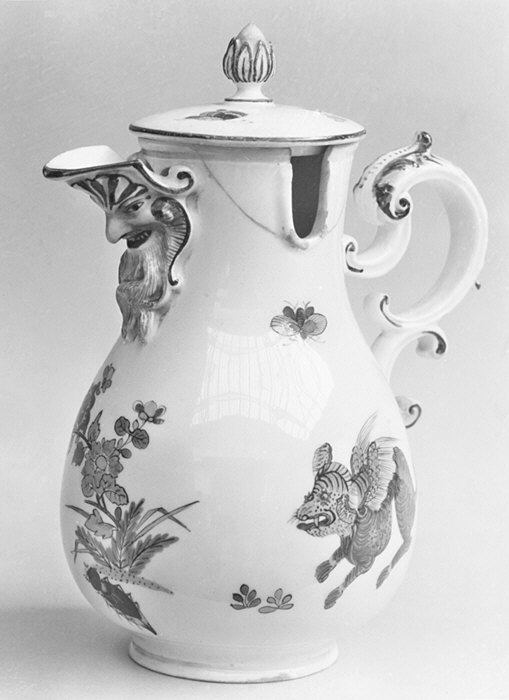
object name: hot milk pot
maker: meissen manufactory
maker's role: manufactory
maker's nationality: german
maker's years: 1710-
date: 1740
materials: hard paste porcelain